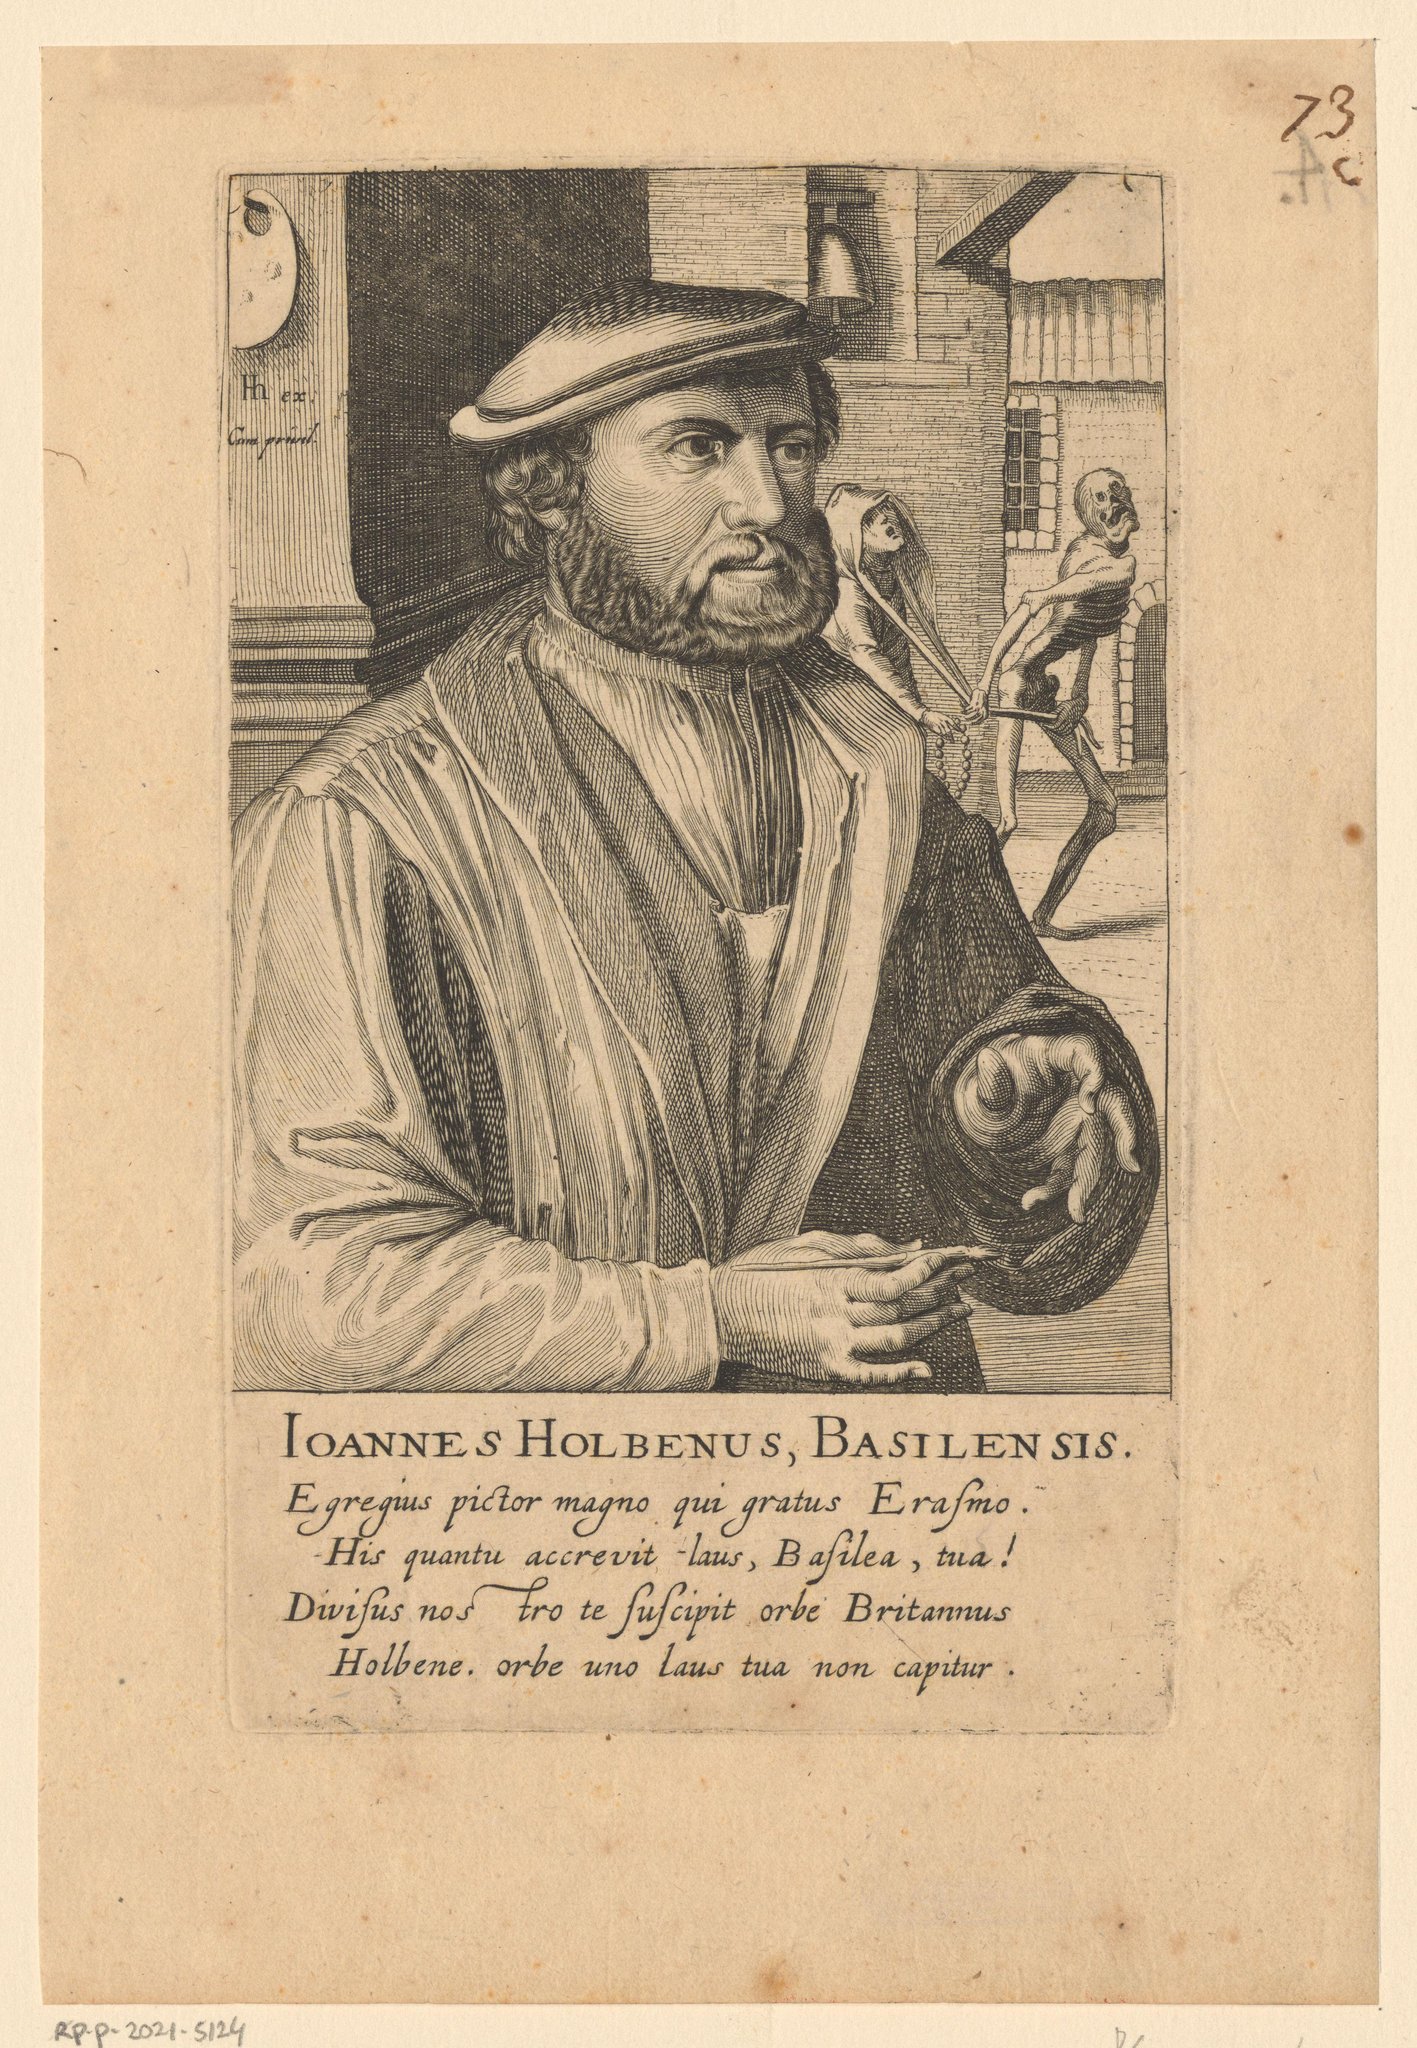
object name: print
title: Portret van Hans Holbein II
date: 1610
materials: paper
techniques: engraving, etching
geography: the hague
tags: augsburg, london, painter, draughtsman, hans holbein (ii), death as skeleton, historical persons, portrait, self-portrait of painter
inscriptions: collector's mark: Lugt 11, inscription: ‘73C’, inscription: ‘7[A/4]’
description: Prent uit deel 2 van de serie 'Pictorum Aliquot Celebrium Praecipuae Germaniae Inferioris Effigies'. Deze serie bestaat uit 72 kunstenaarsportretten vervaardigd door Hendrick Hondius I, Simon Frisius, Andries Jacobsz. Stock en Robert de Baudous.